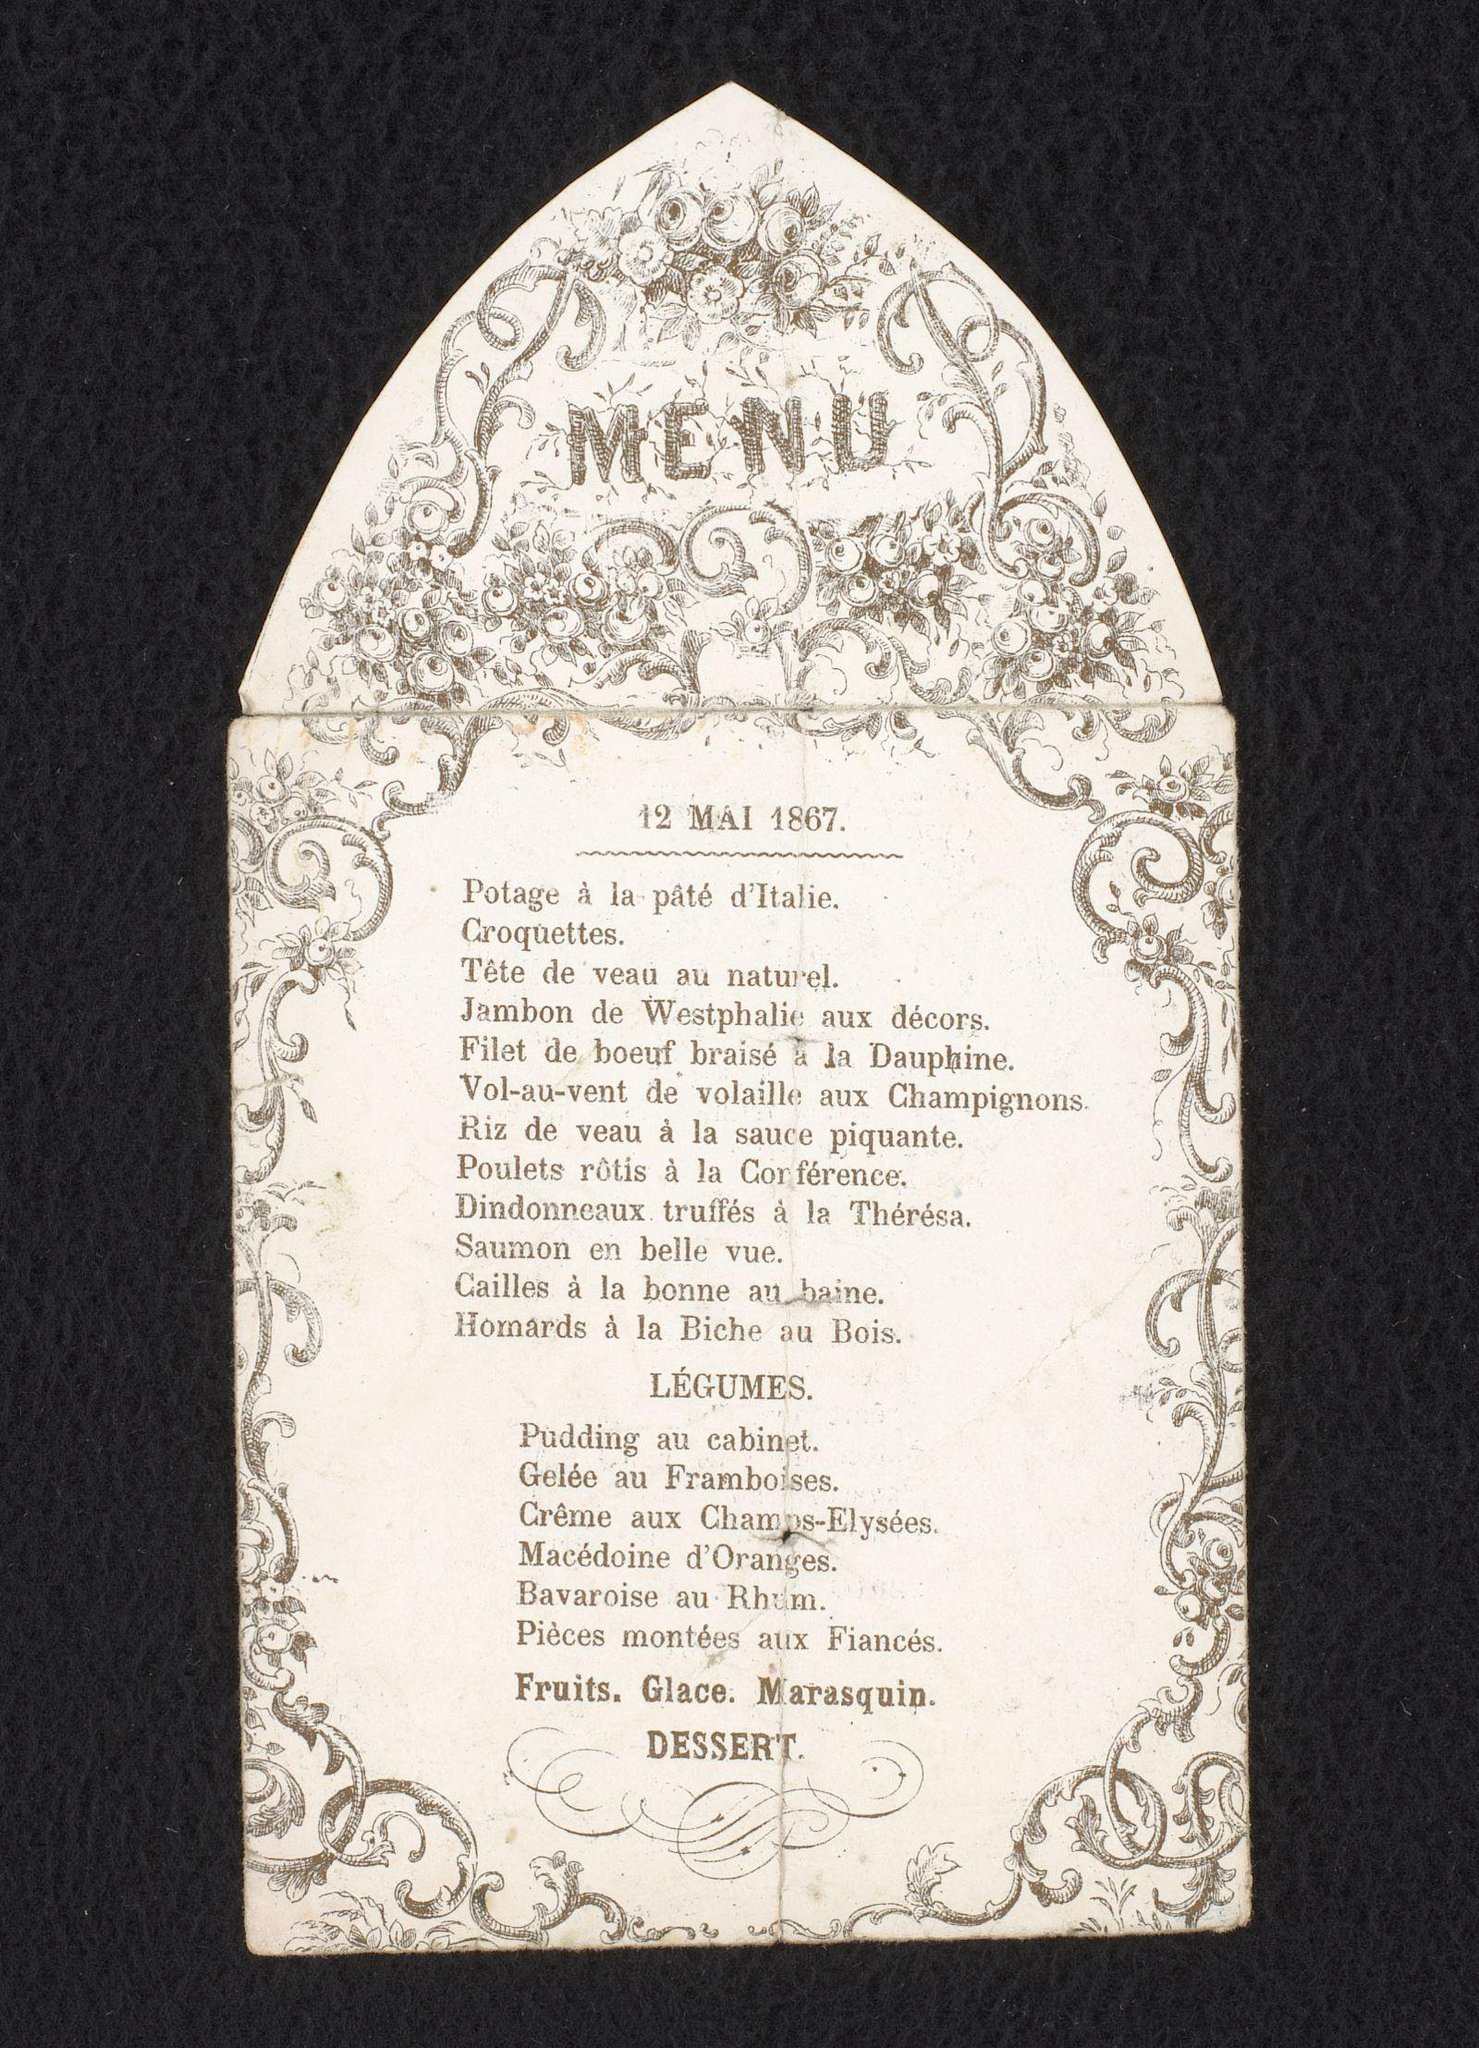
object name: photomechanical print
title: Menukaart voor een diner op 12 mei 1867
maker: Anonymous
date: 1867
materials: paper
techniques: printing block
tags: ornament derived from plant forms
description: Op de voorzijde decoratie van rozen en bladeren, met in het midden (handgeschreven) 'Mme. v.d. Dungen'. Op de achterzijde eveneens een botanisch decoratief kader met in het midden daarvan de tekst van het menu.